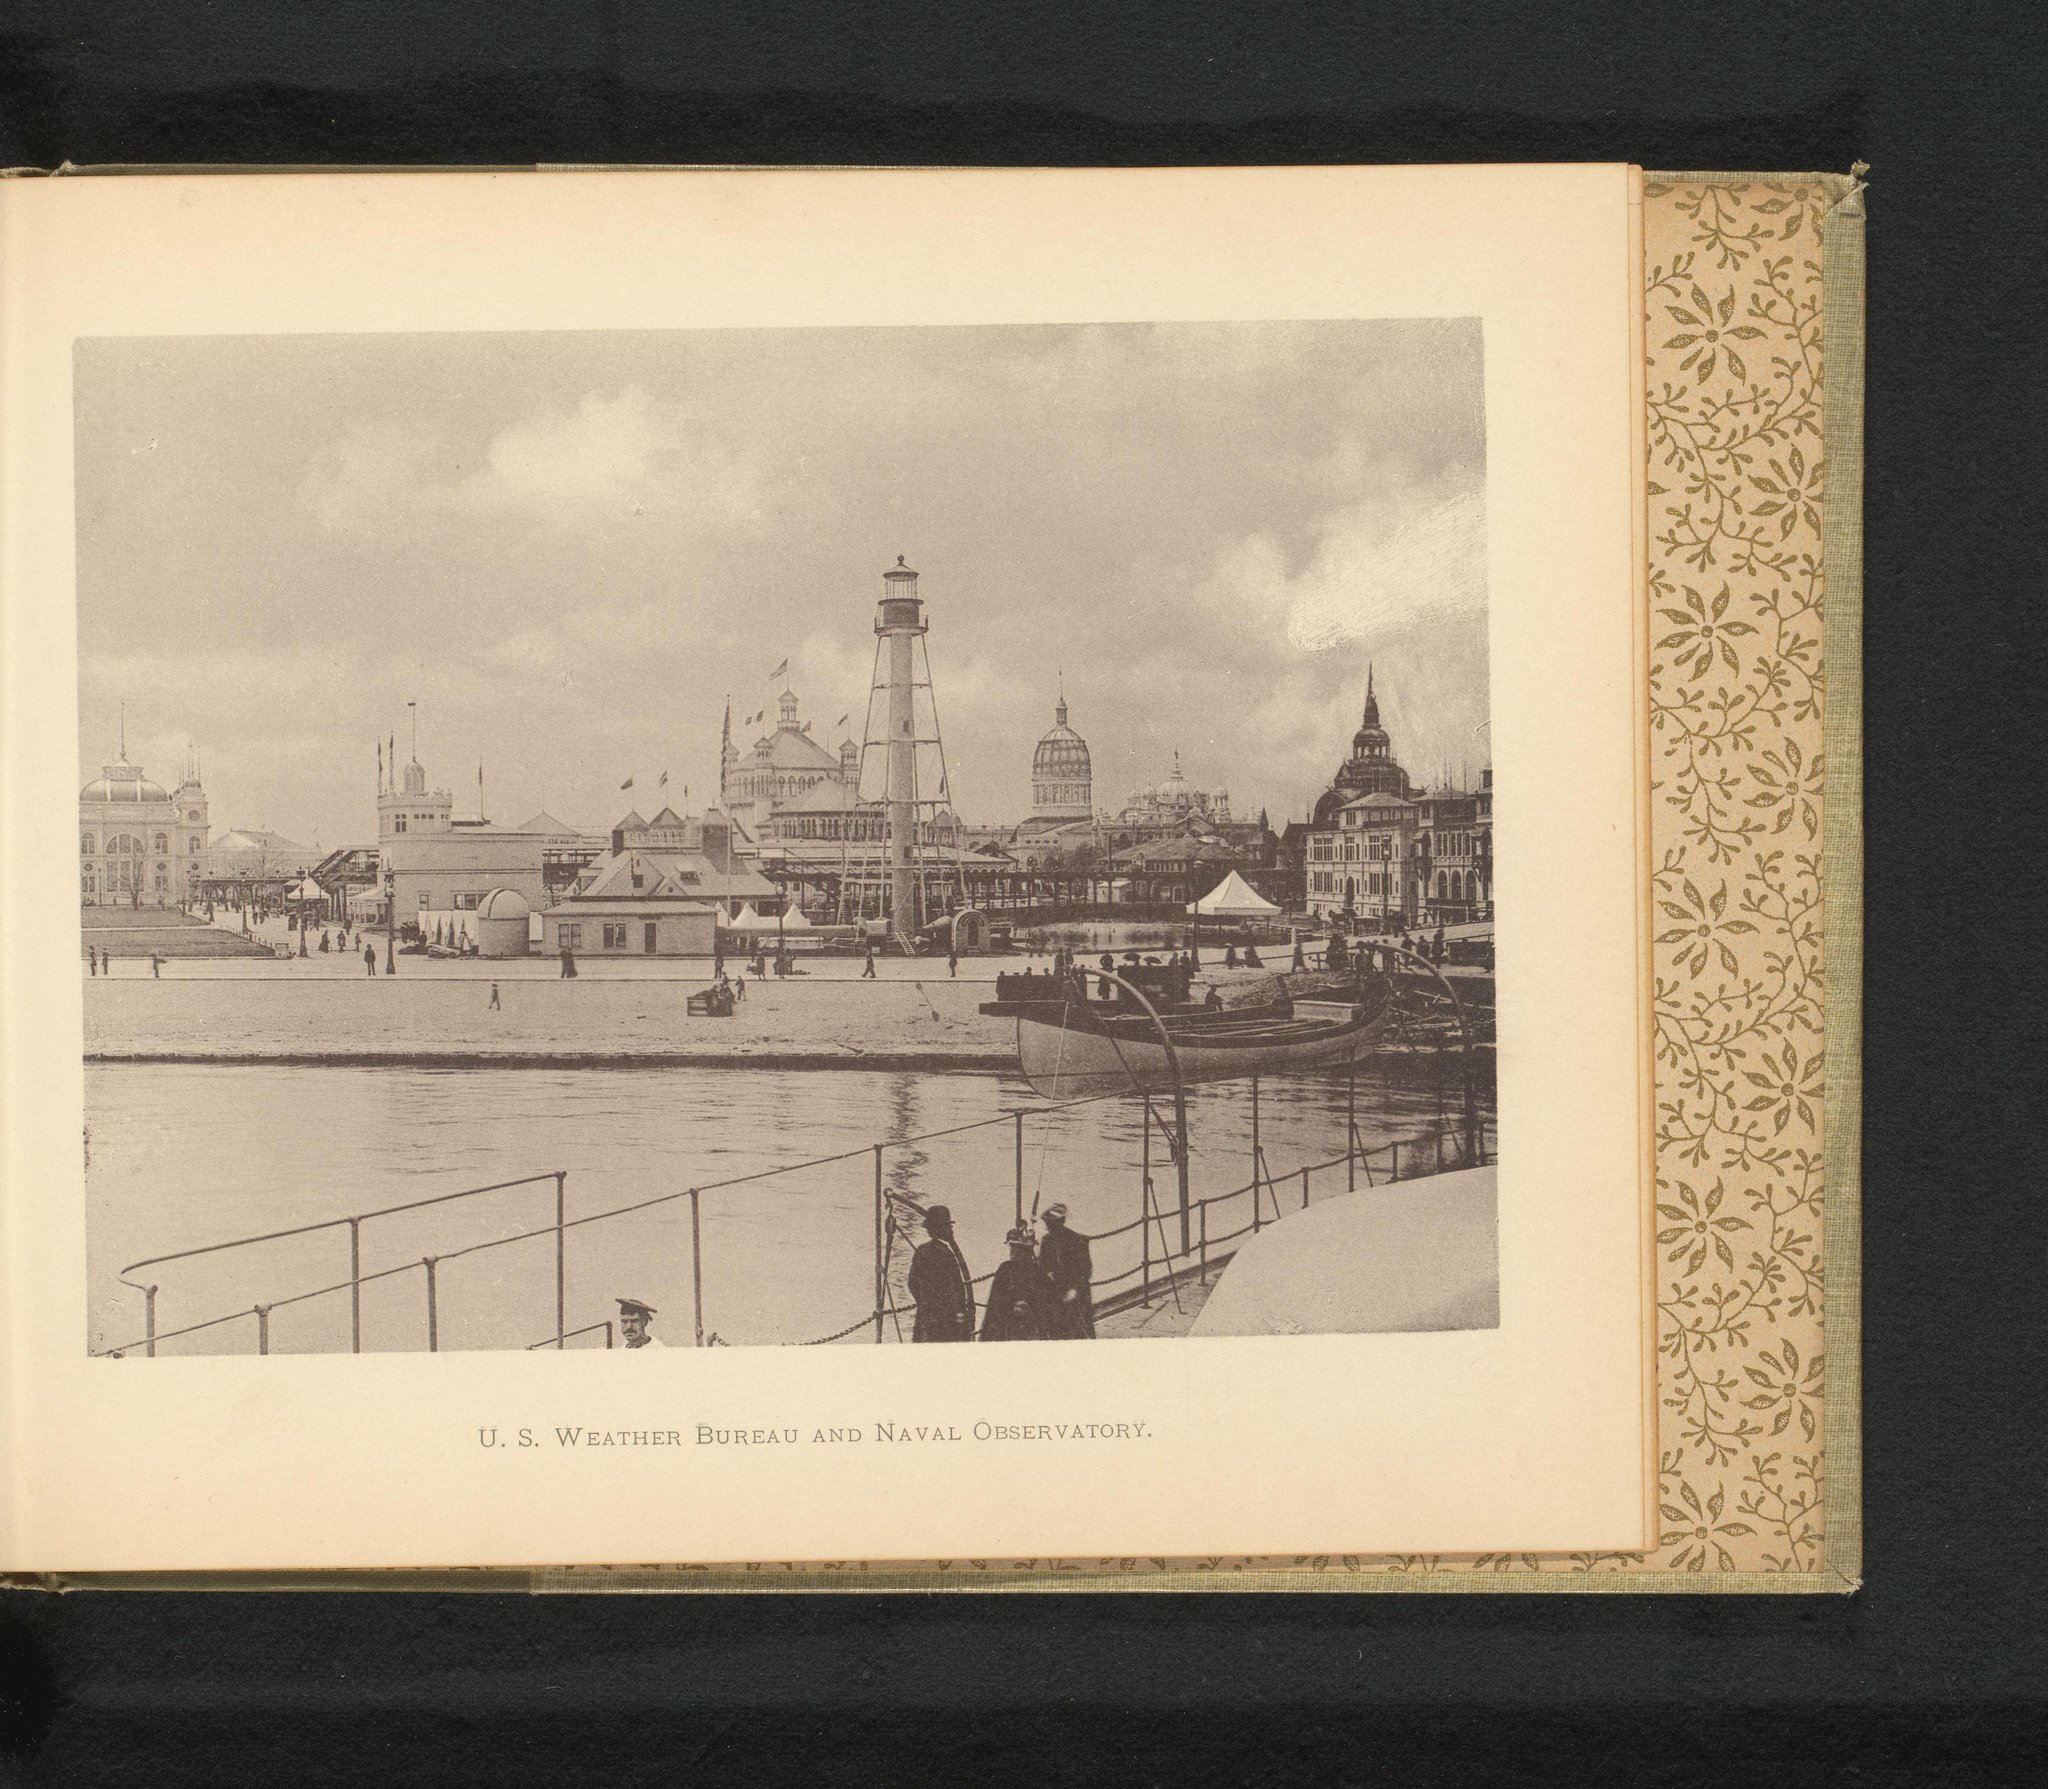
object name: photomechanical print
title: U.S. Weather Bureau and Naval Observatory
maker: Anonymous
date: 1893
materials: paper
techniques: photograph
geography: chicago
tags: world fair, world exhibition, rowing-boat, canoe, etc.